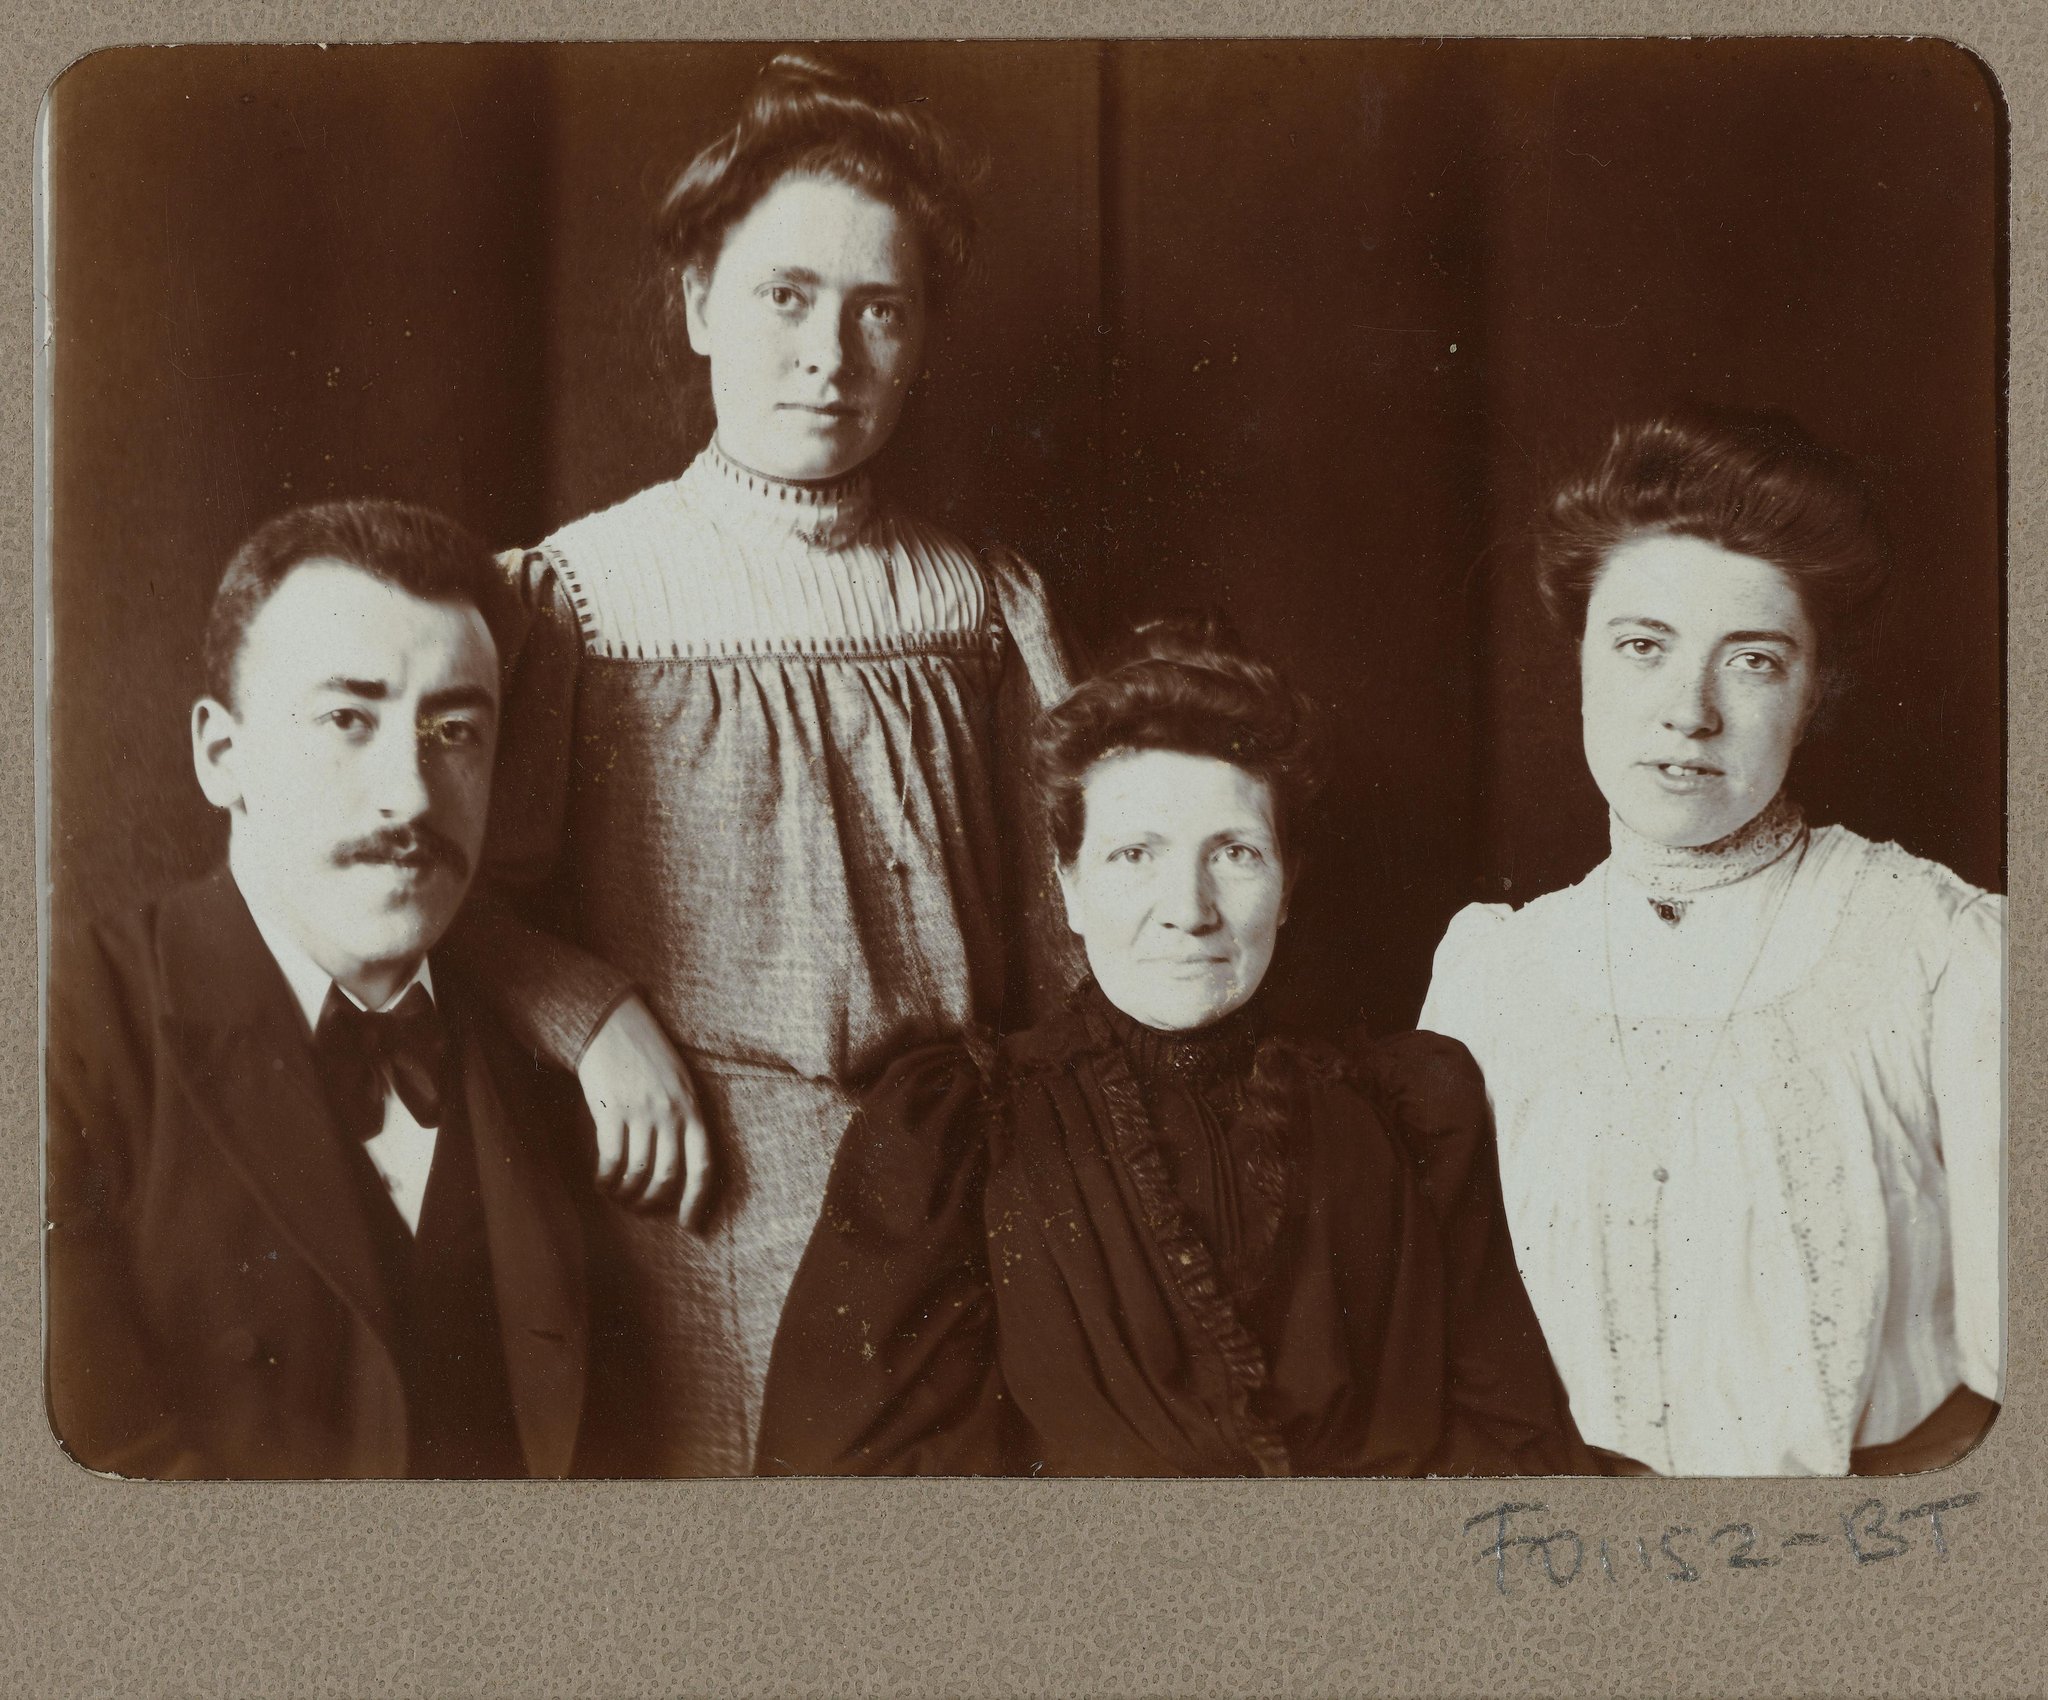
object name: album leaf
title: Groepsportret van drie vrouwen en Christiaan Otto Roelofs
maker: christiaan otto roelofs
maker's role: fotograaf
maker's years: 1882-1970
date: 1900-1915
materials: photographic support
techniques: gelatin silver print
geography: netherlands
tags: amsterdam, christiaan otto roelofs, adult man, historical persons, adult woman (+ three persons)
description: De vrouwen zijn mogelijk de moeder van Christiaan Otto Roelofs en zijn twee zusters.